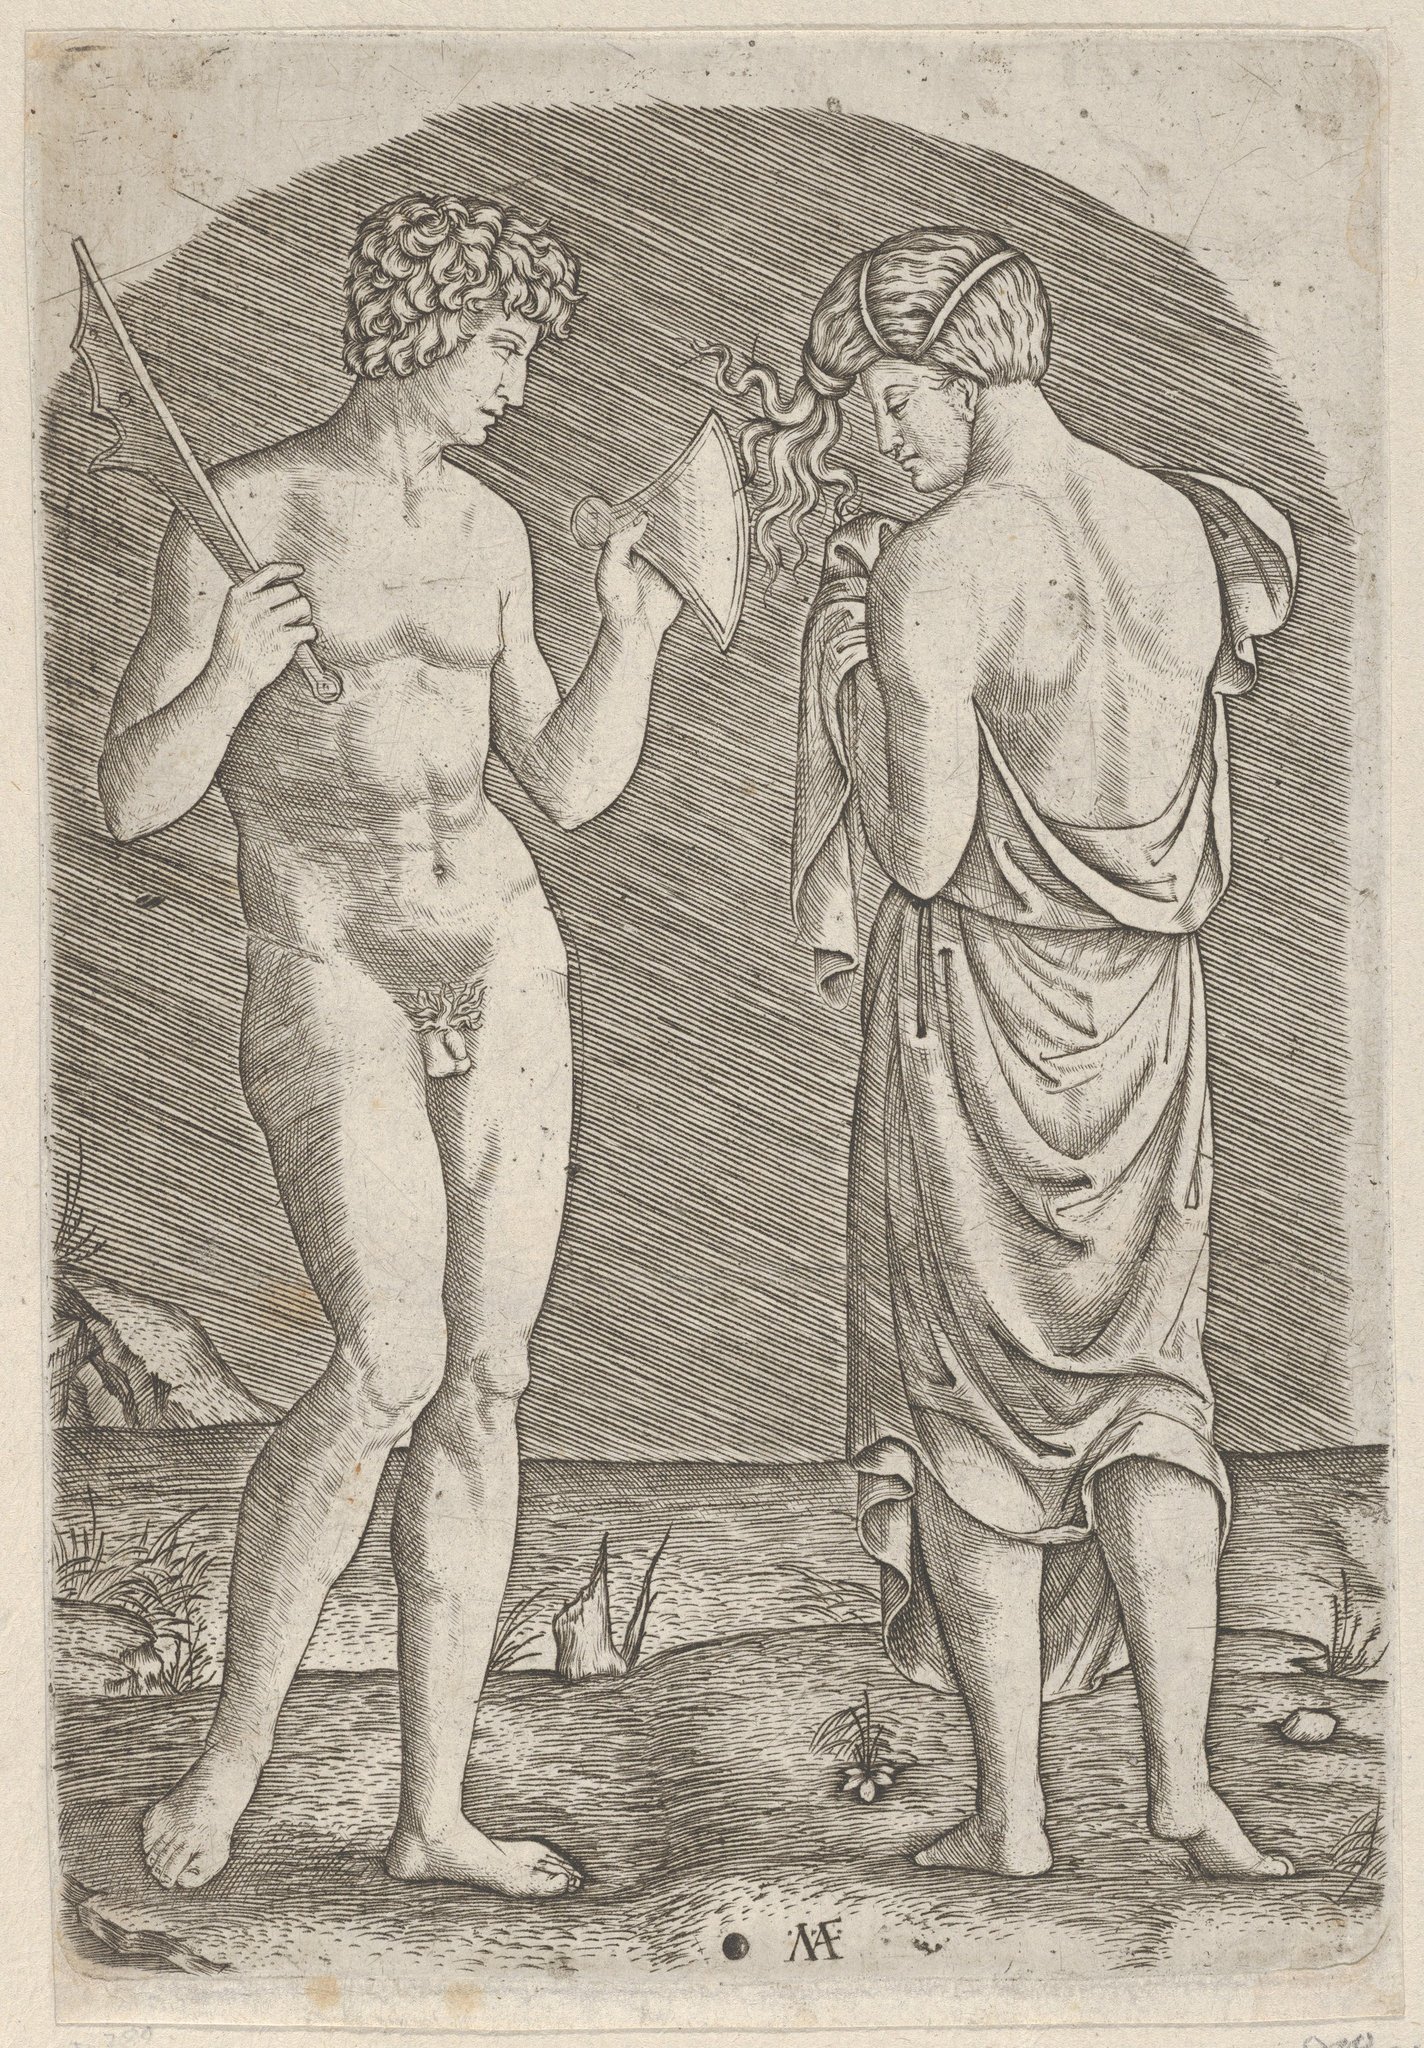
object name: print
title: A naked man at left showing an axe to a woman at right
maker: marcantonio raimondi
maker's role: artist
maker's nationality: italian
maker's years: 1475-1534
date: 1510-1527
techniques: engraving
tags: male nudes,women,axes